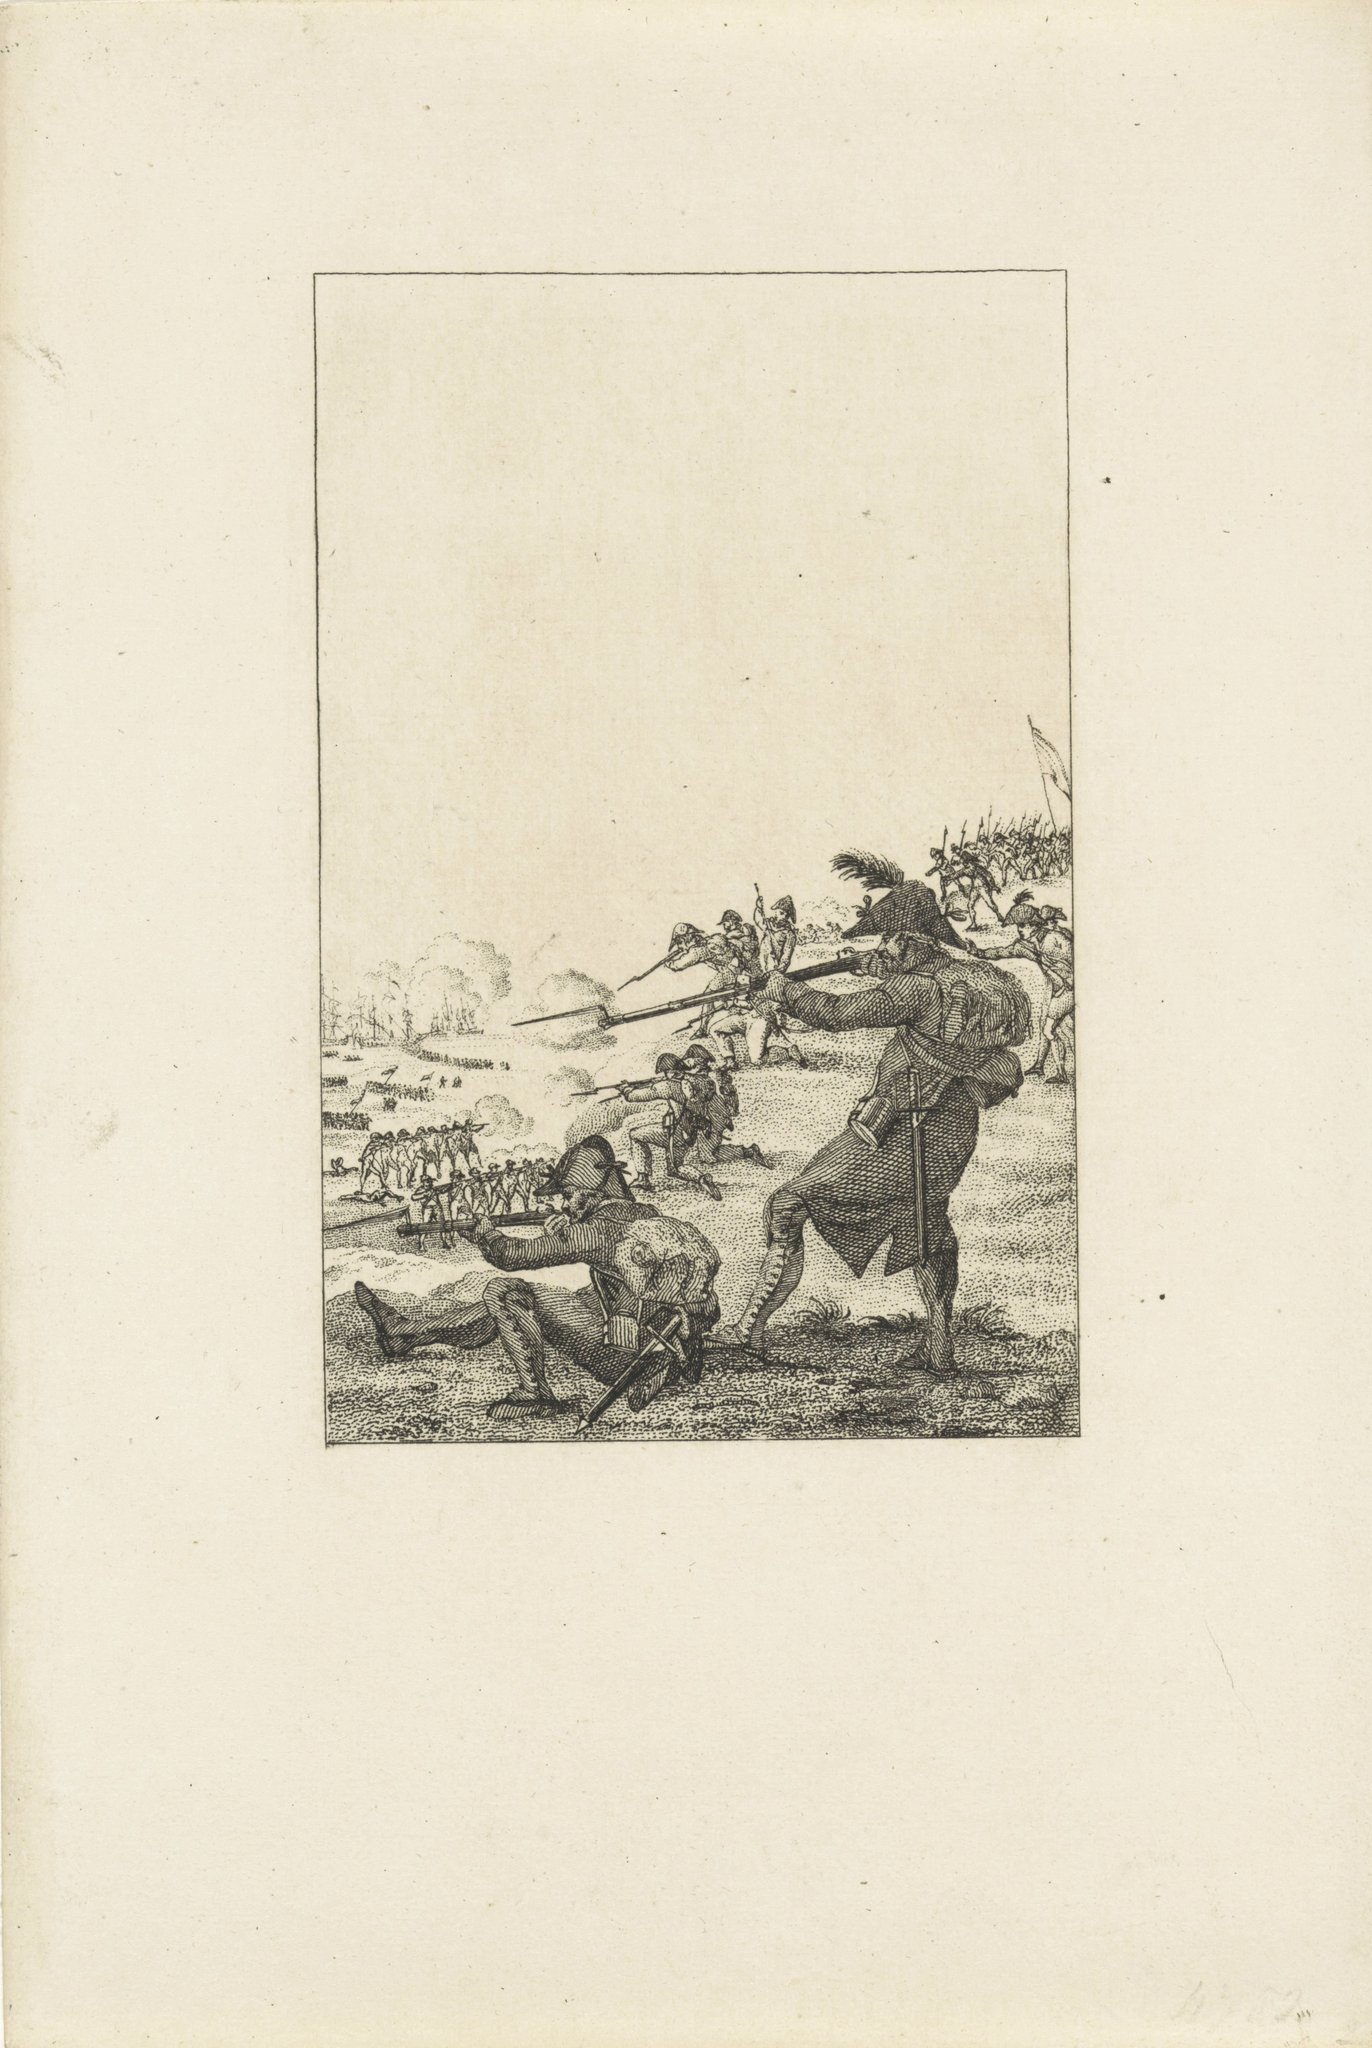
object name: print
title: Landing van de Britten bij Callantsoog, 1799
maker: reinier vinkeles (i)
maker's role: draughtsman, print maker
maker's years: 1741-1816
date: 1806-1808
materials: paper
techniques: etching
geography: netherlands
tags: (military) attack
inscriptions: collector's mark: Lugt 2228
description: Gebruikt als illustratie in: P.A. Loosjes. Vaderlandsche historie, vervattende de geschiedenissen, der Vereenigde Nederlanden (...). Ten onmiddelyken vervolge van Wagenaar's Vaderlandsche historie. Amsterdam: Johannes Allart, dl. 41 (1808).